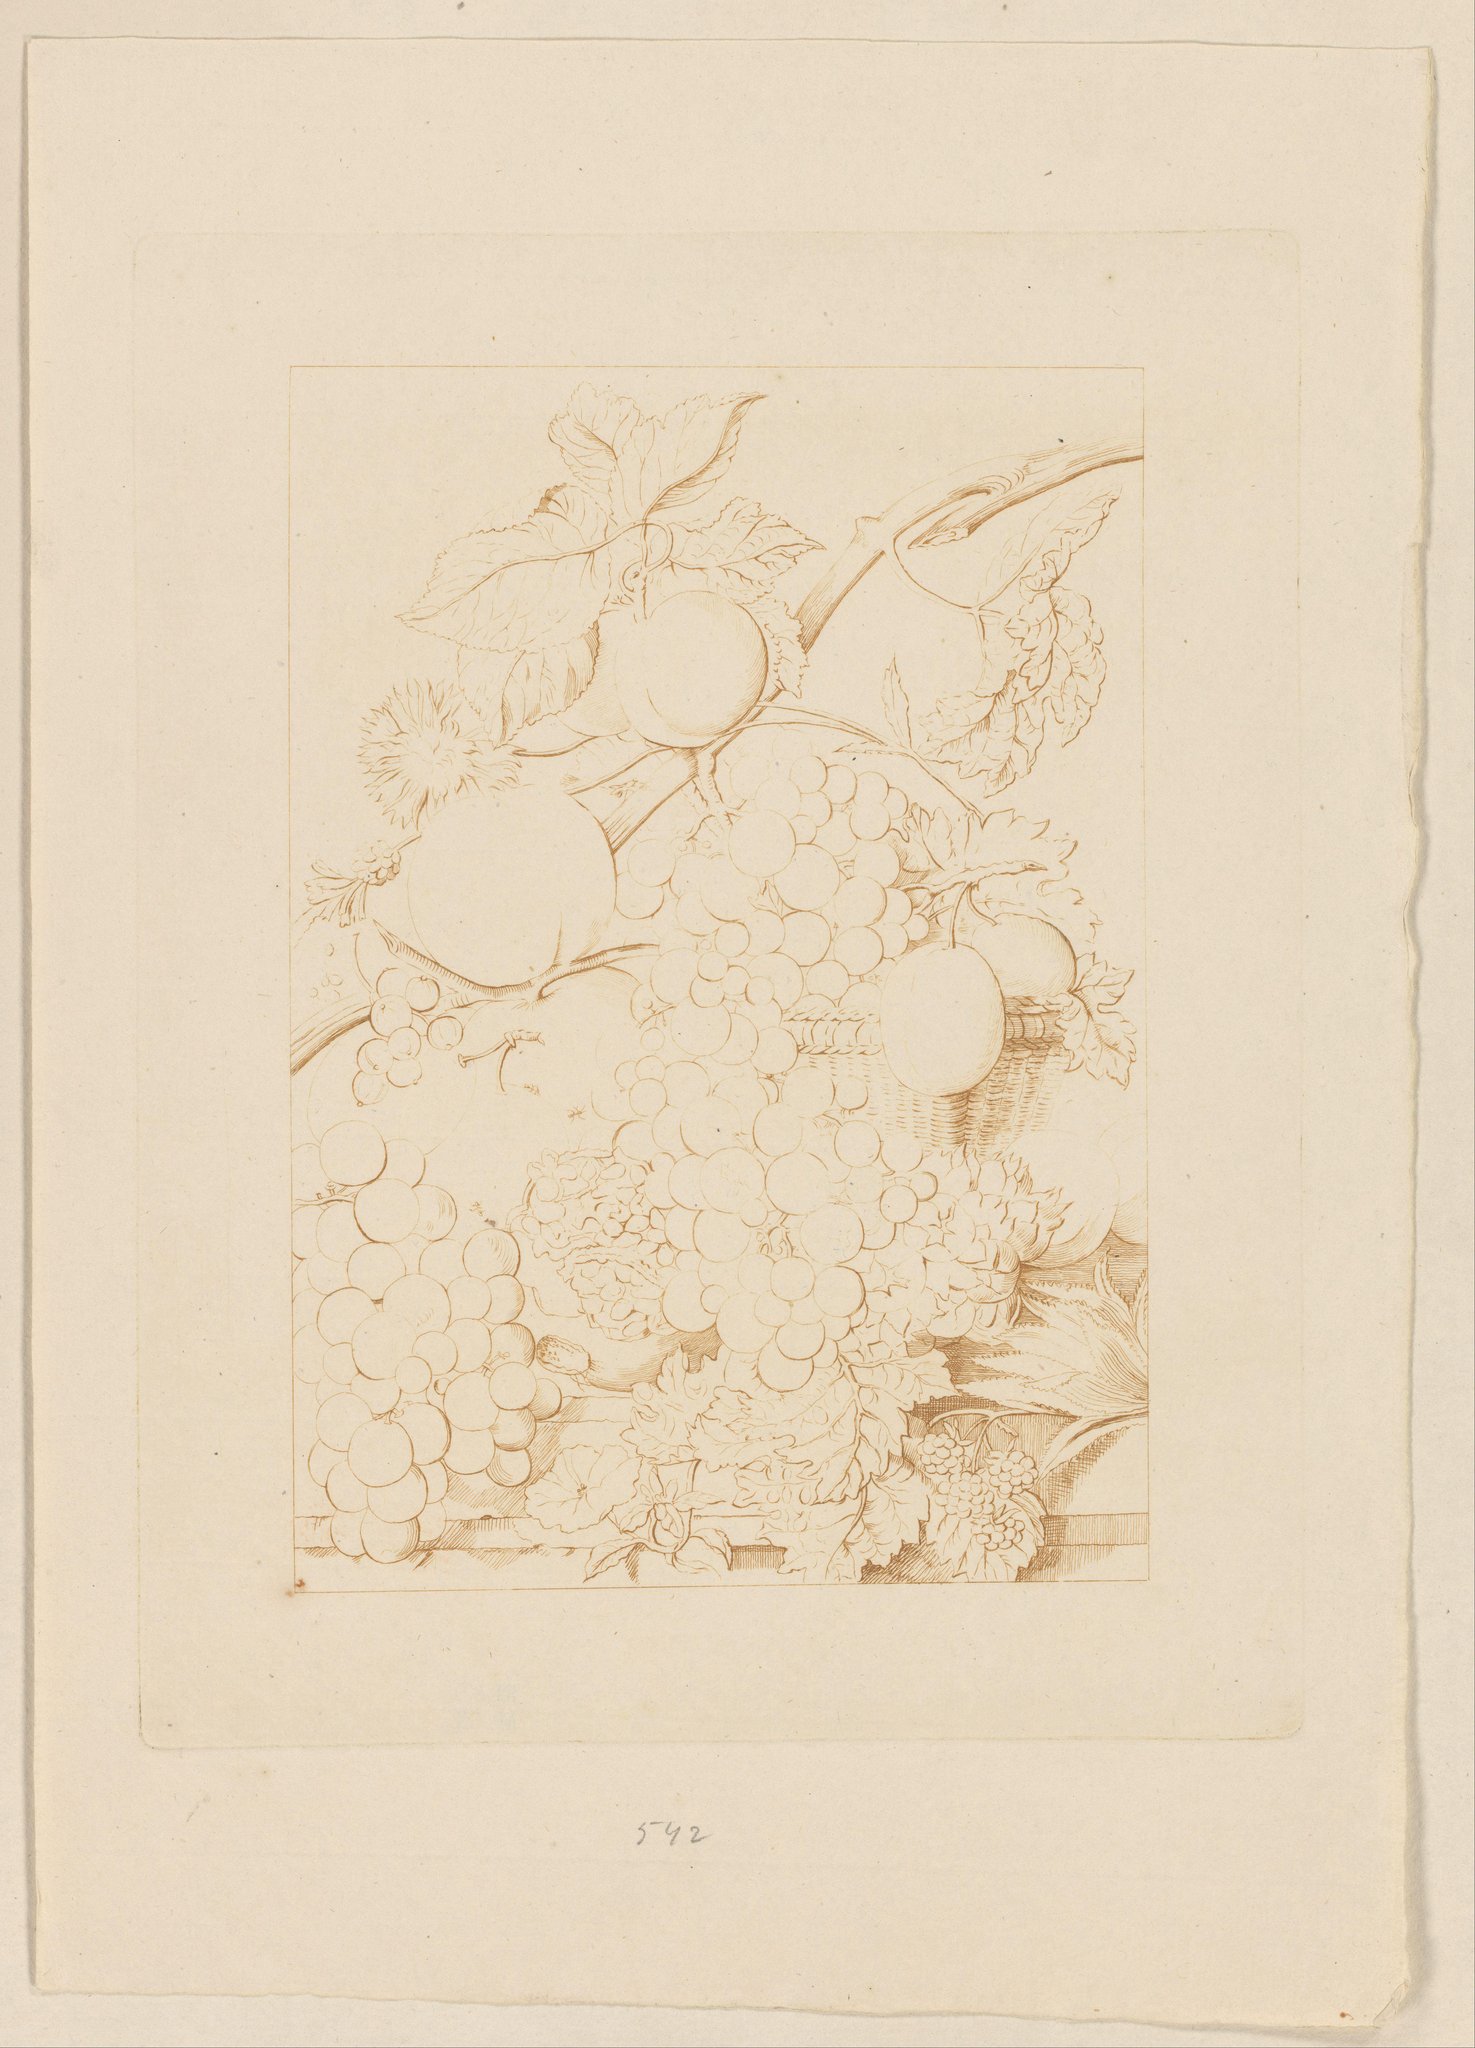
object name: print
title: Fruitstuk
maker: cornelis ploos van amstel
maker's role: draughtsman, print maker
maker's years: 1726-1798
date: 1777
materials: paper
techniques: etching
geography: amsterdam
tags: fruits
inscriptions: collector's mark: ‘RIJKS / MUSM’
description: De prent ligt los in een album, zie blad 67